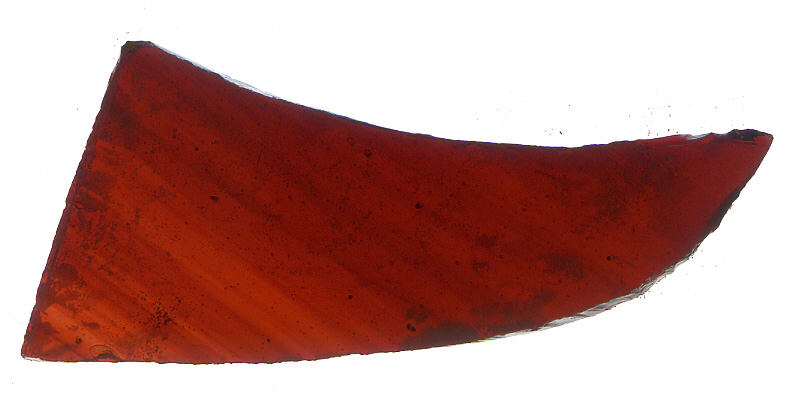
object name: fragment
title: Glass Fragment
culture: european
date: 1301-1400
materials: glass, metal